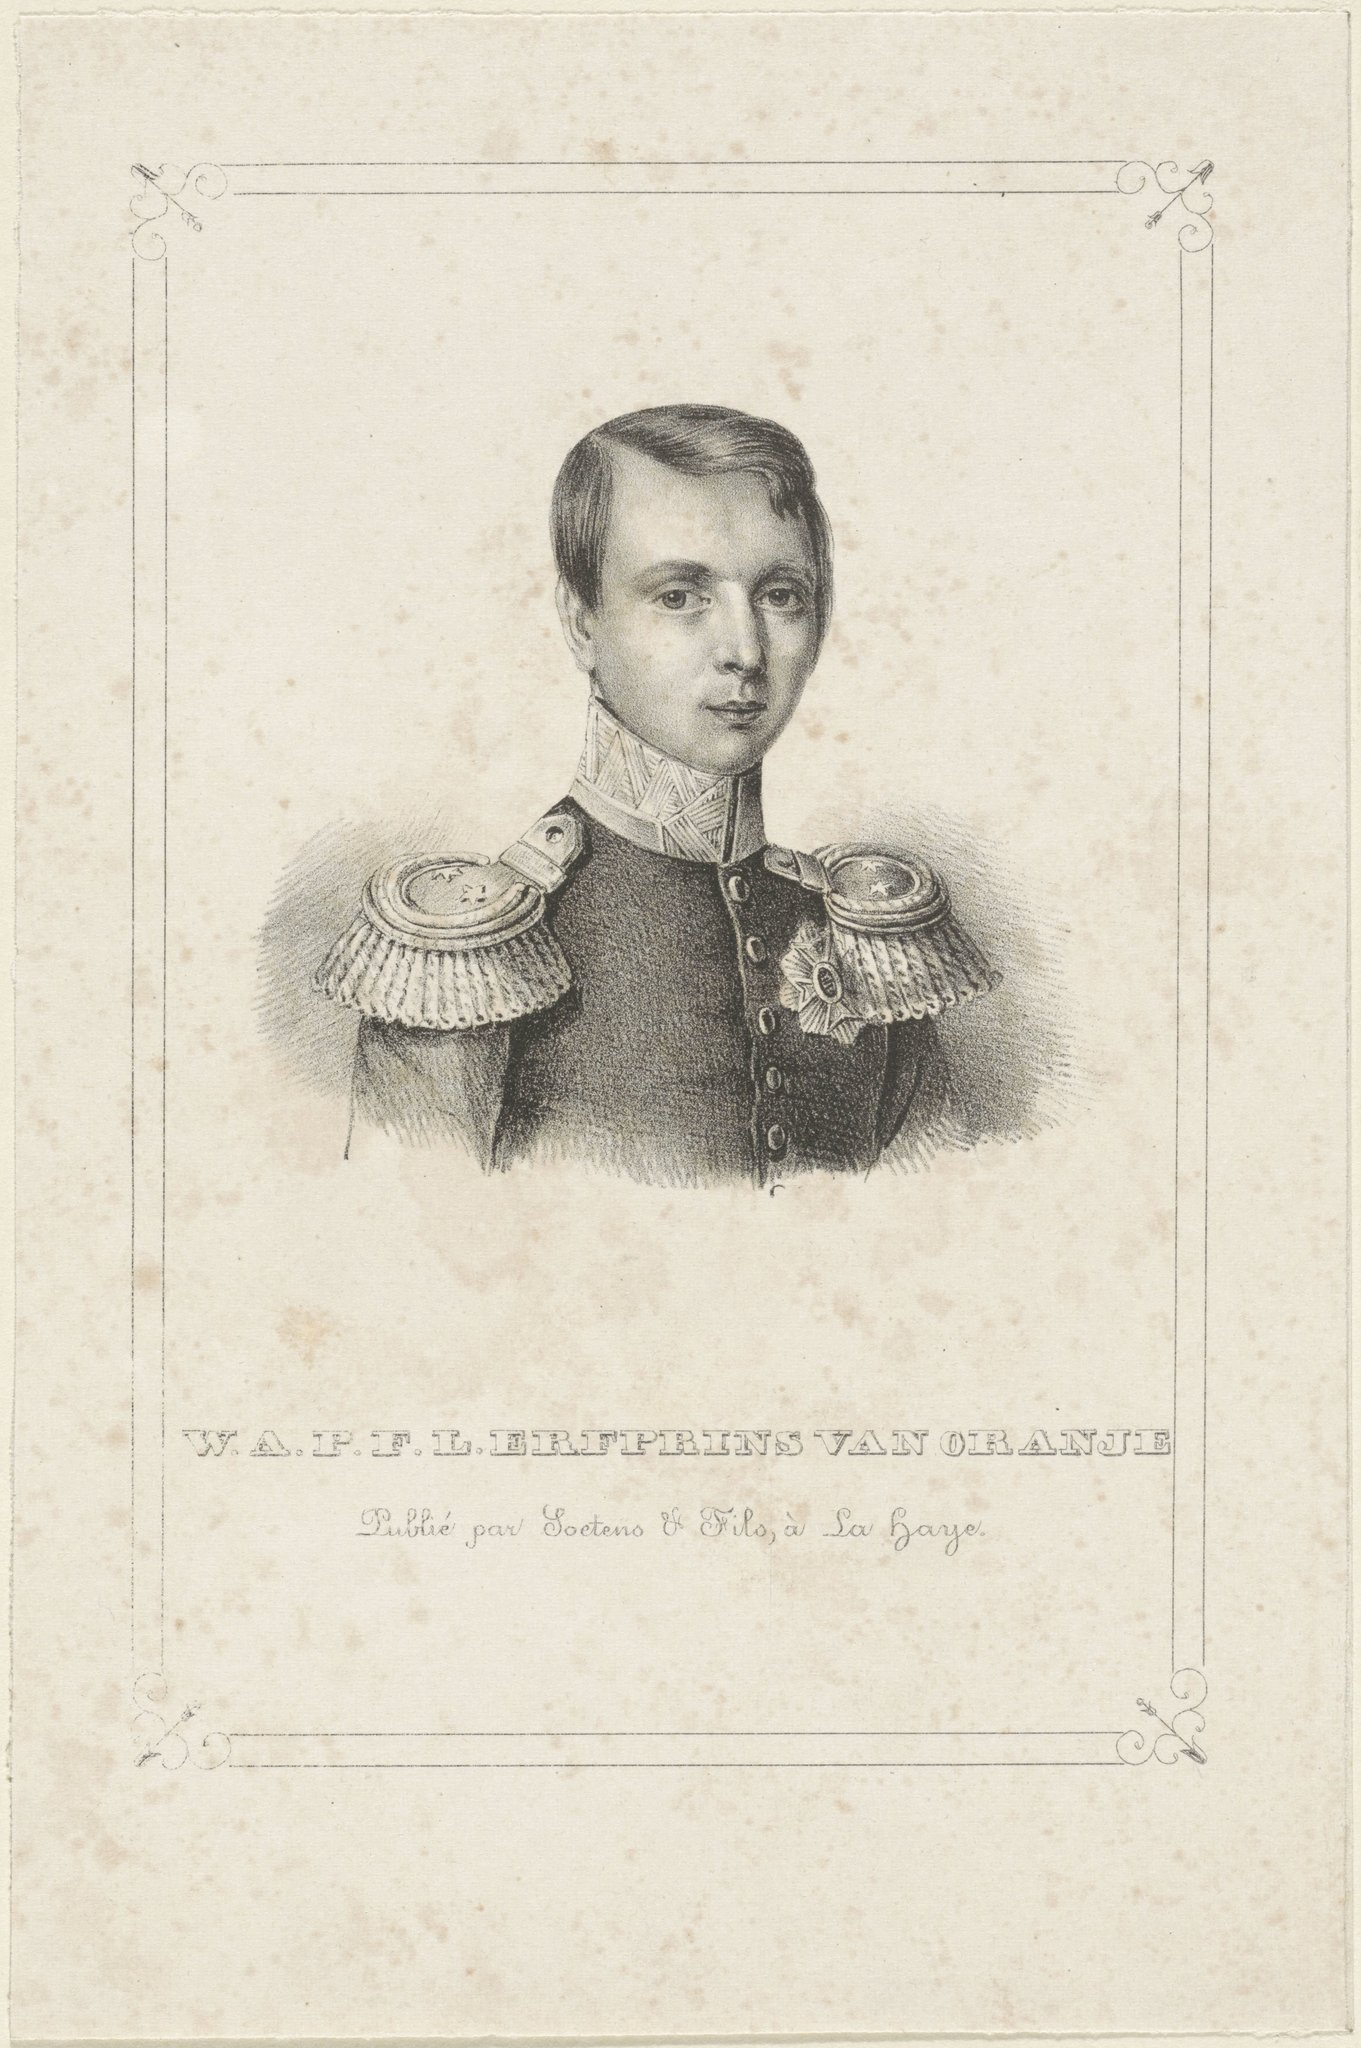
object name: print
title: Portret van Willem III, koning der Nederlanden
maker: Anonymous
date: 1837-1840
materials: paper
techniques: lithograph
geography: netherlands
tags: brussels, willem iii (koning der nederlanden)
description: De hier vermelde titel verwijst naar de hoogst verkregen titel van de geportretteerde, niet per se naar de titel die de geportretteerde op deze voorstelling draagt.